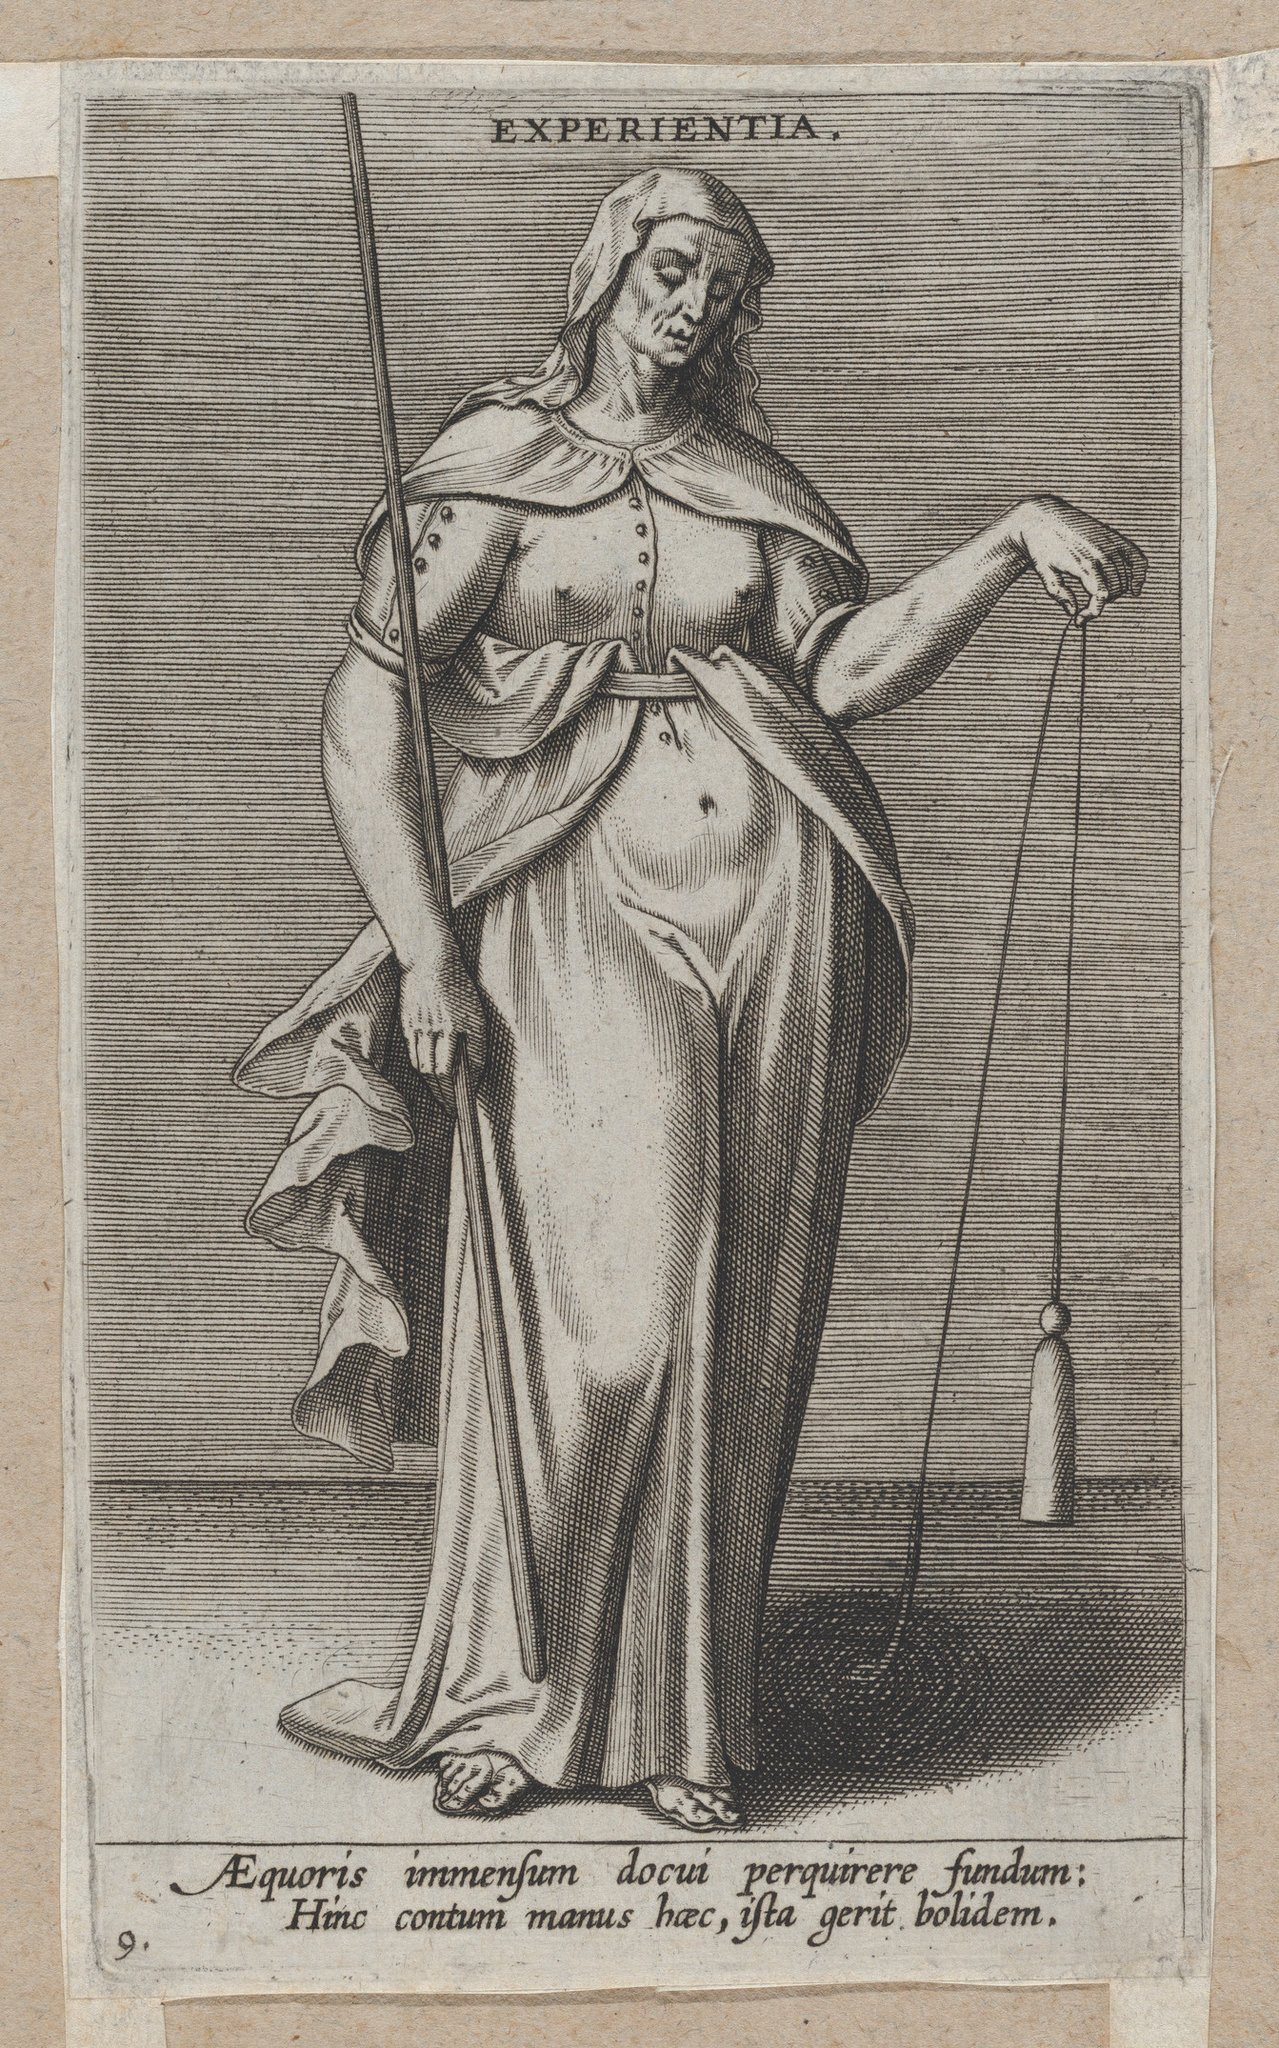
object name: print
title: Experientia, from "Proposopographia"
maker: philips galle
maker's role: artist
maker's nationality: netherlandish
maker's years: 1537-1612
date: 1585-1590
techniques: engraving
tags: women